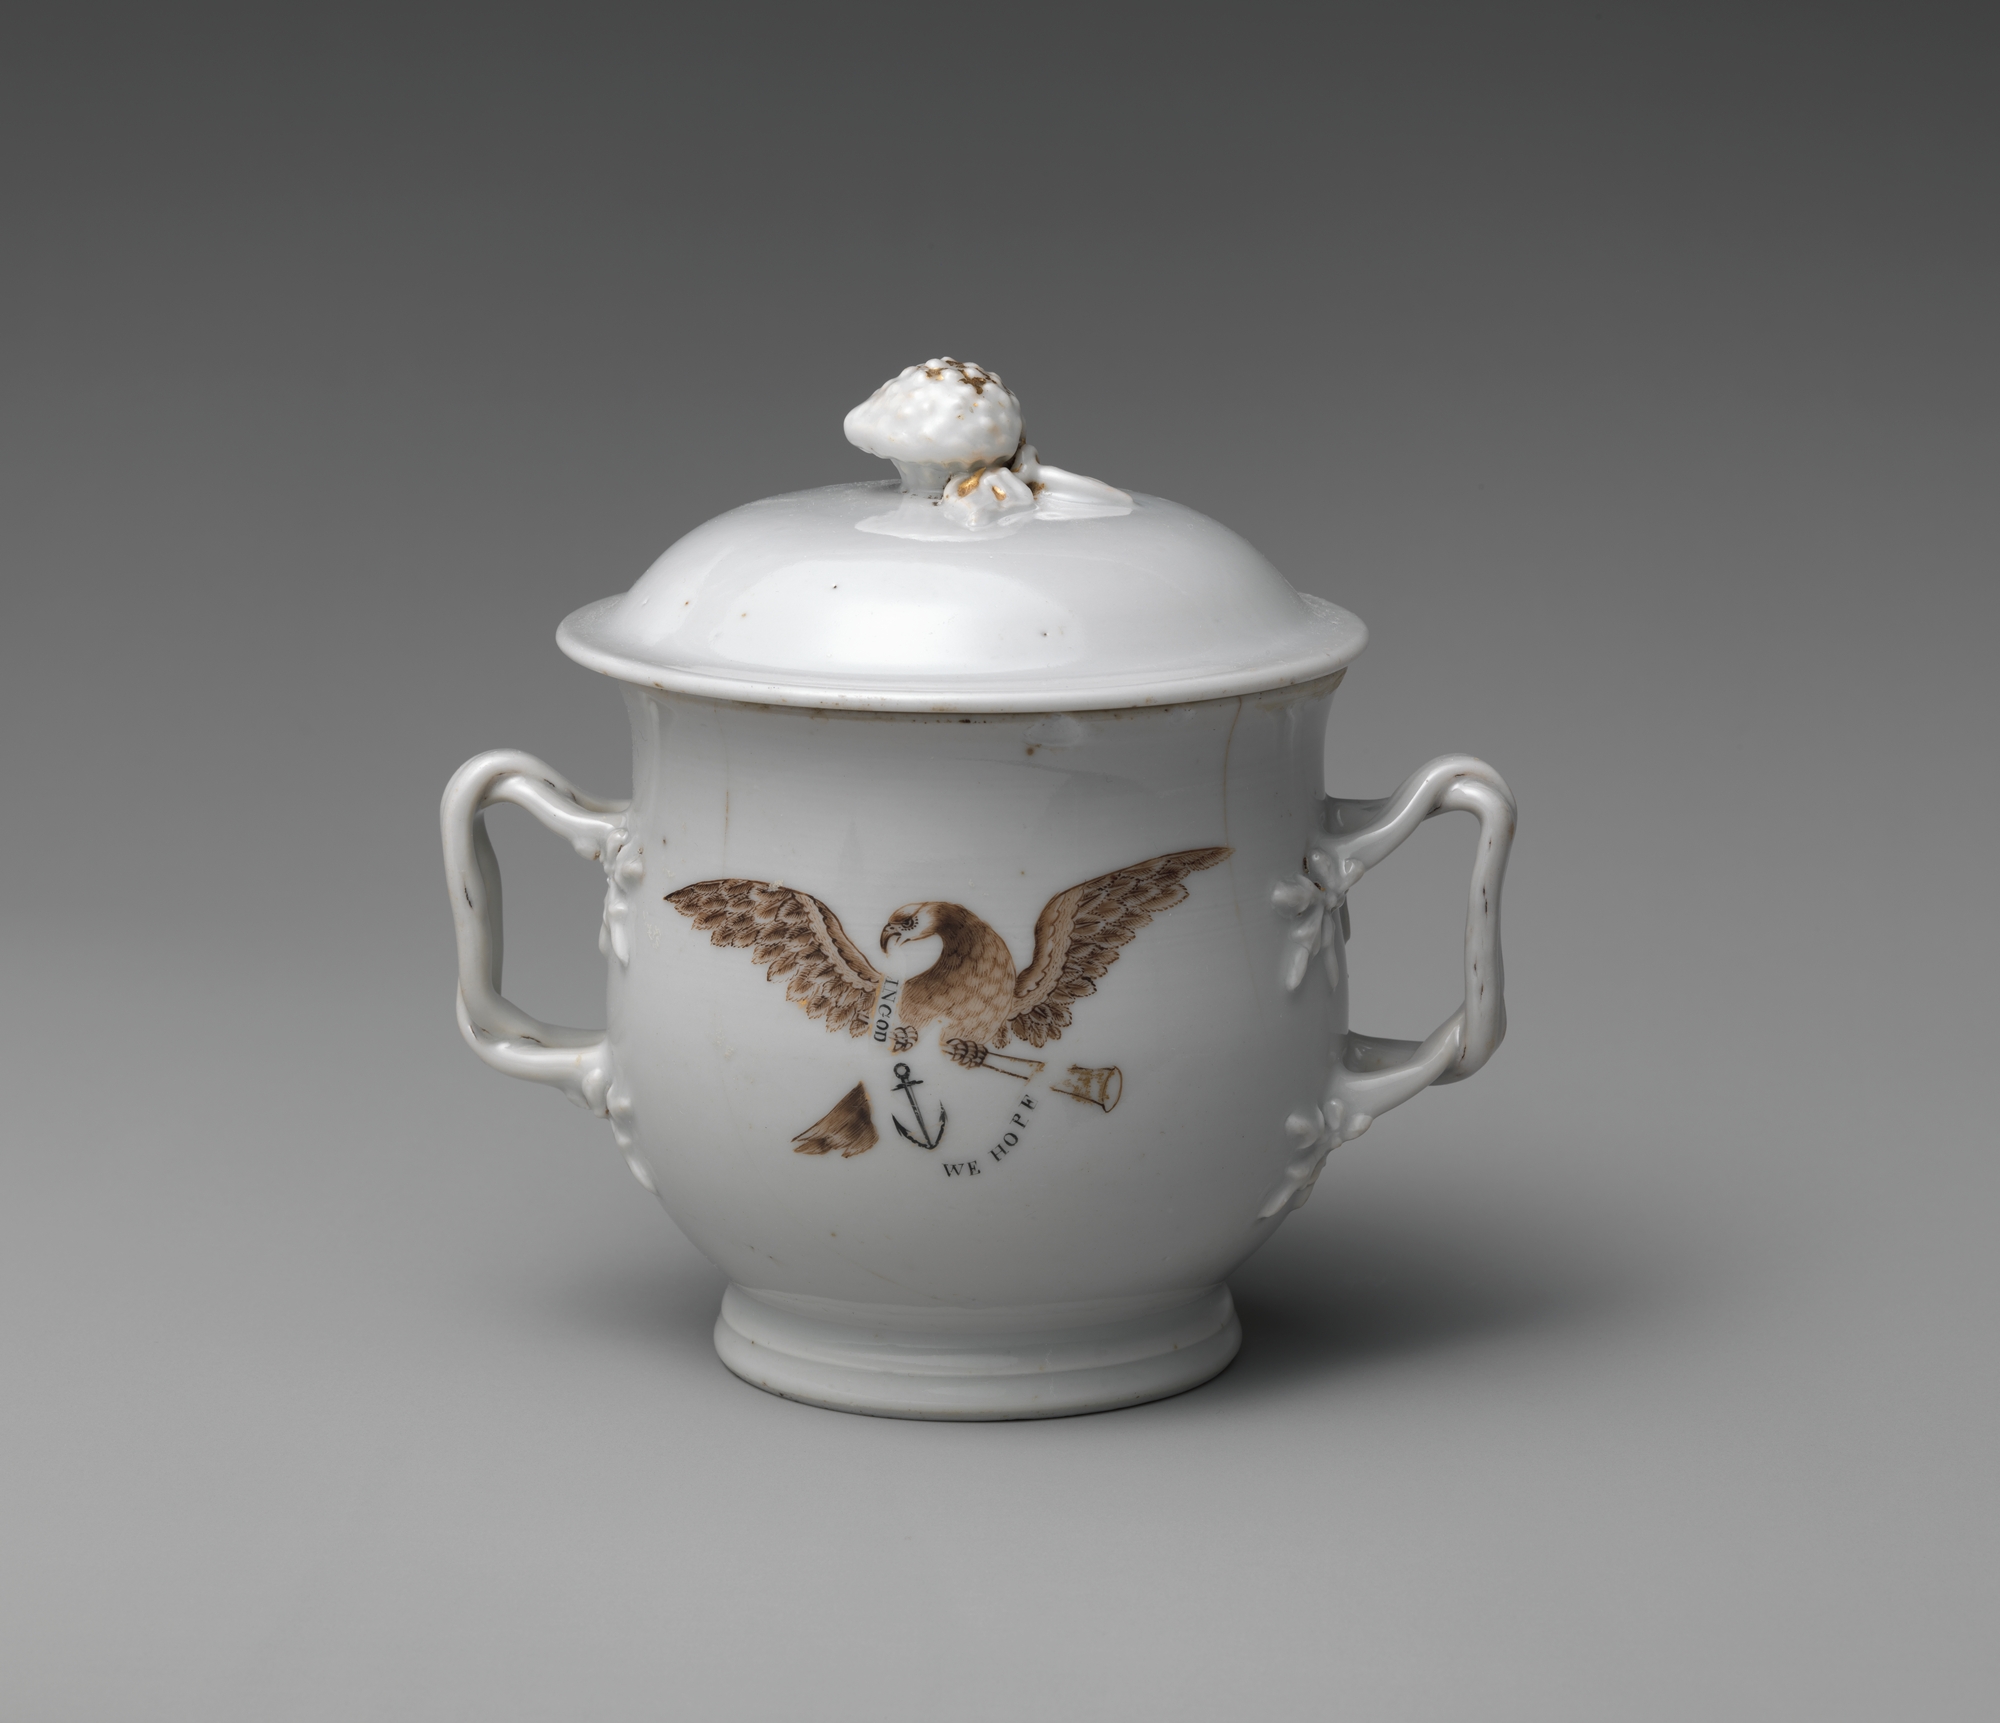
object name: sugar bowl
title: Covered Sugar Bowl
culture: chinese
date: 1790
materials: porcelain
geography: china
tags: eagles